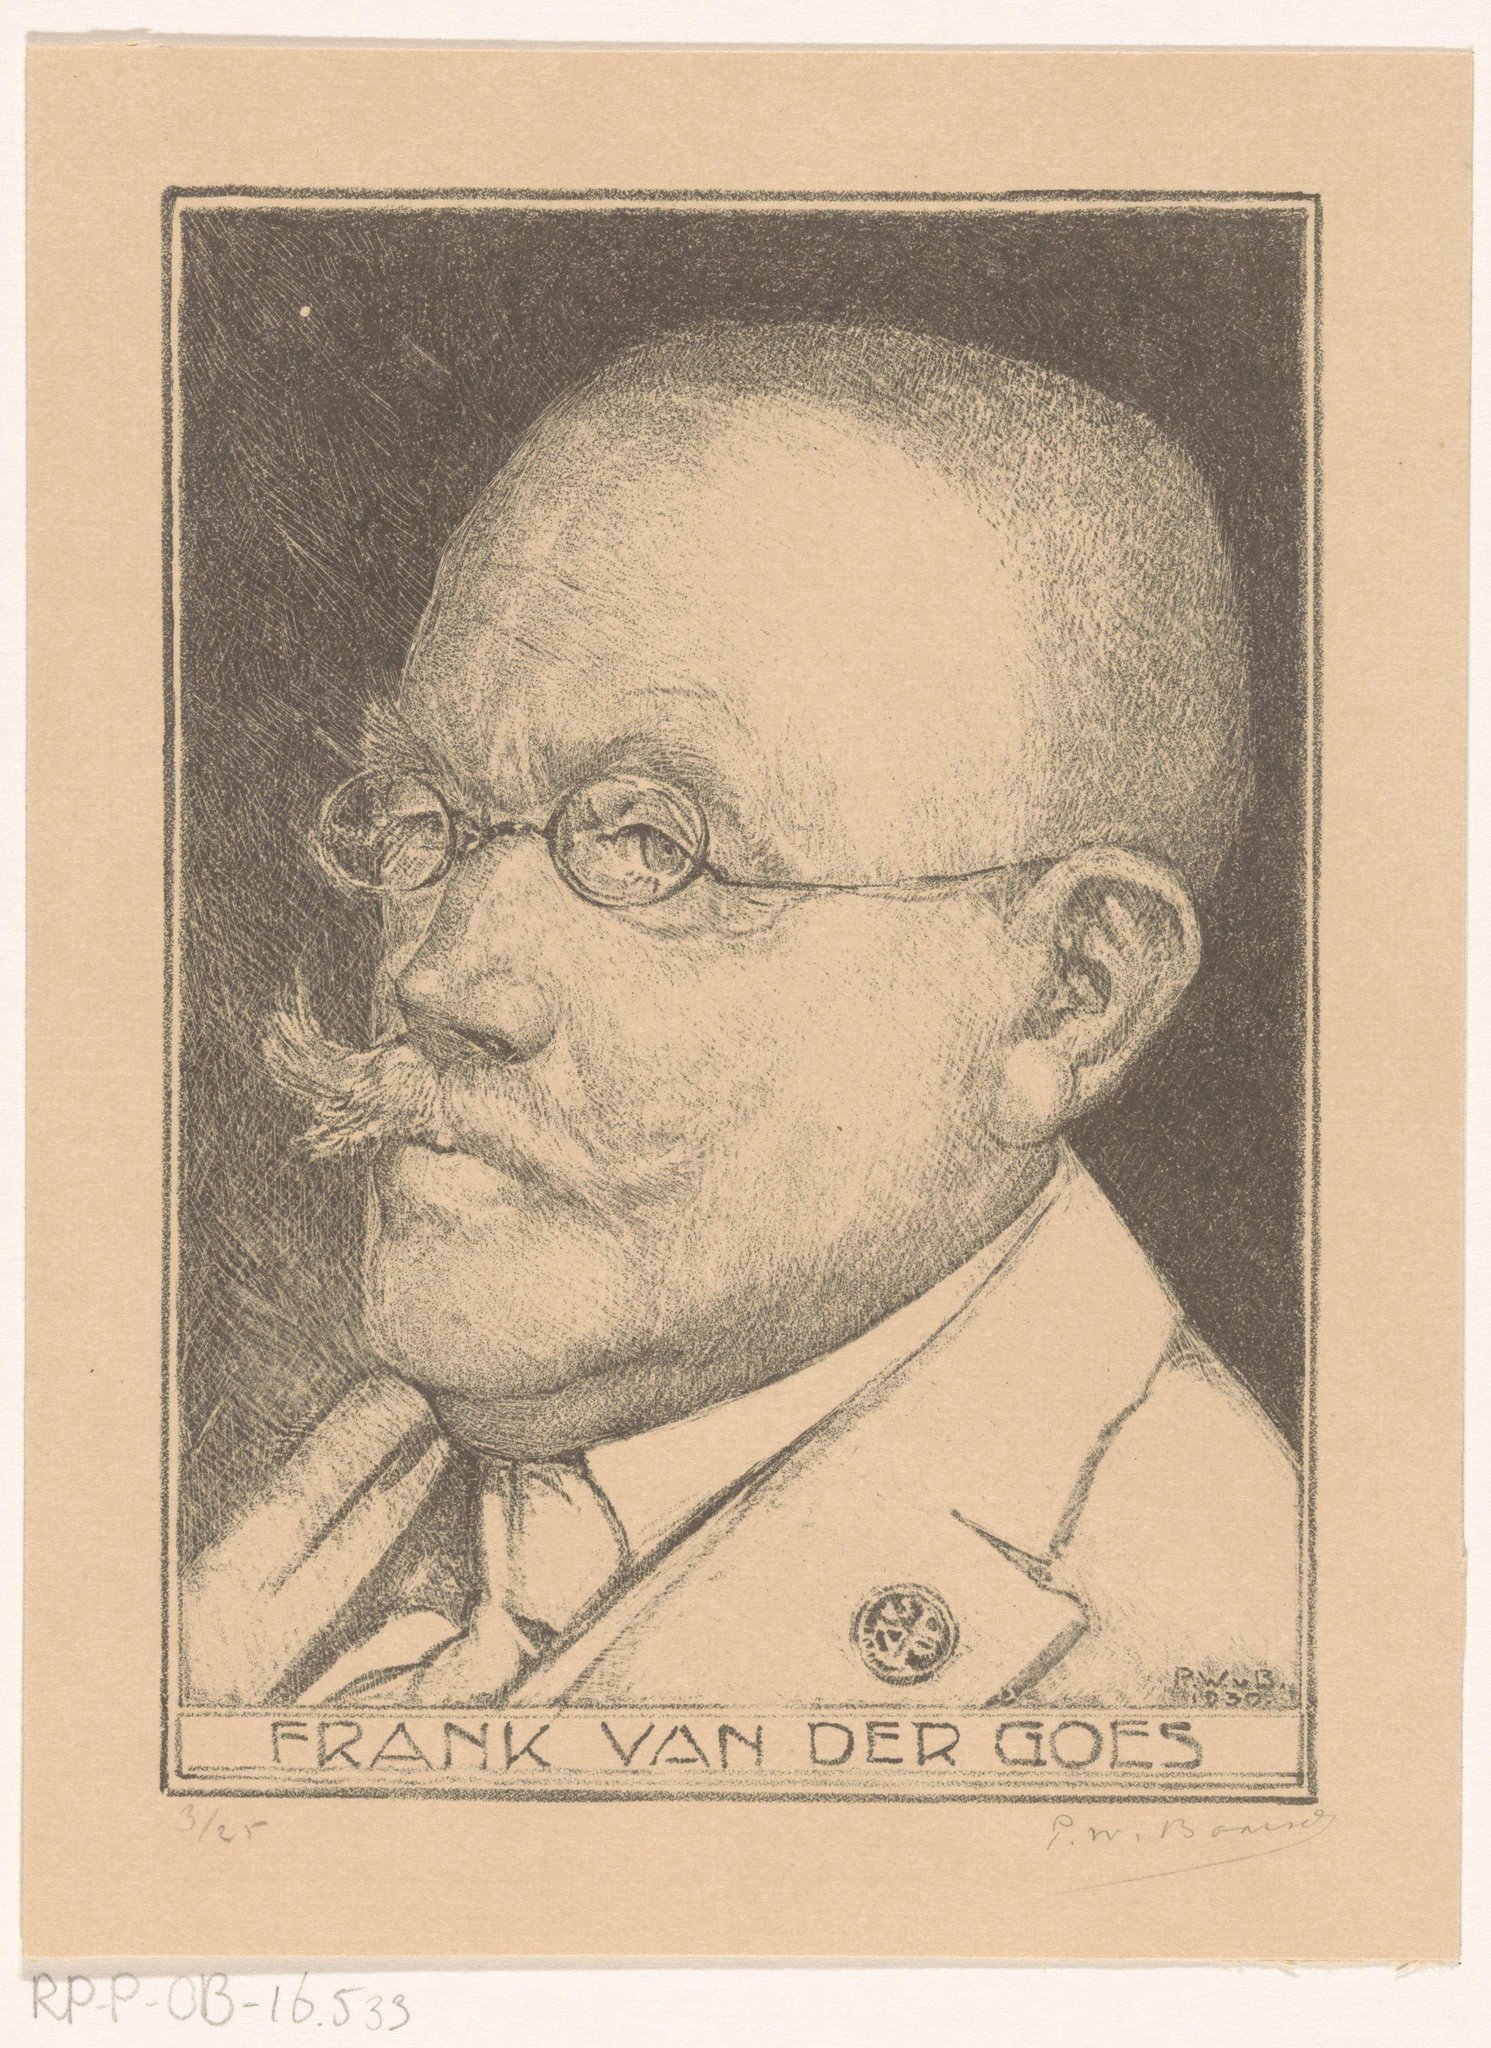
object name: print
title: Portret van Frank van der Goes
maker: pieter willem van baarsel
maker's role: draughtsman, painter, print maker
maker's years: 1879-1949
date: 1930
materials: paper, ink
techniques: lithograph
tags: amsterdam, frank van der goes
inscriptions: collector's mark: Lugt 2228, monogram and date: ‘P.W.v.B. 1930’, signature: ‘P.W. Baarsel’, title: ‘FRANK VAN DER GOES’, edition: ‘3/25’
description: Schouderstuk van een man met snor en bril, met zijn hoofd schuin naar rechts.